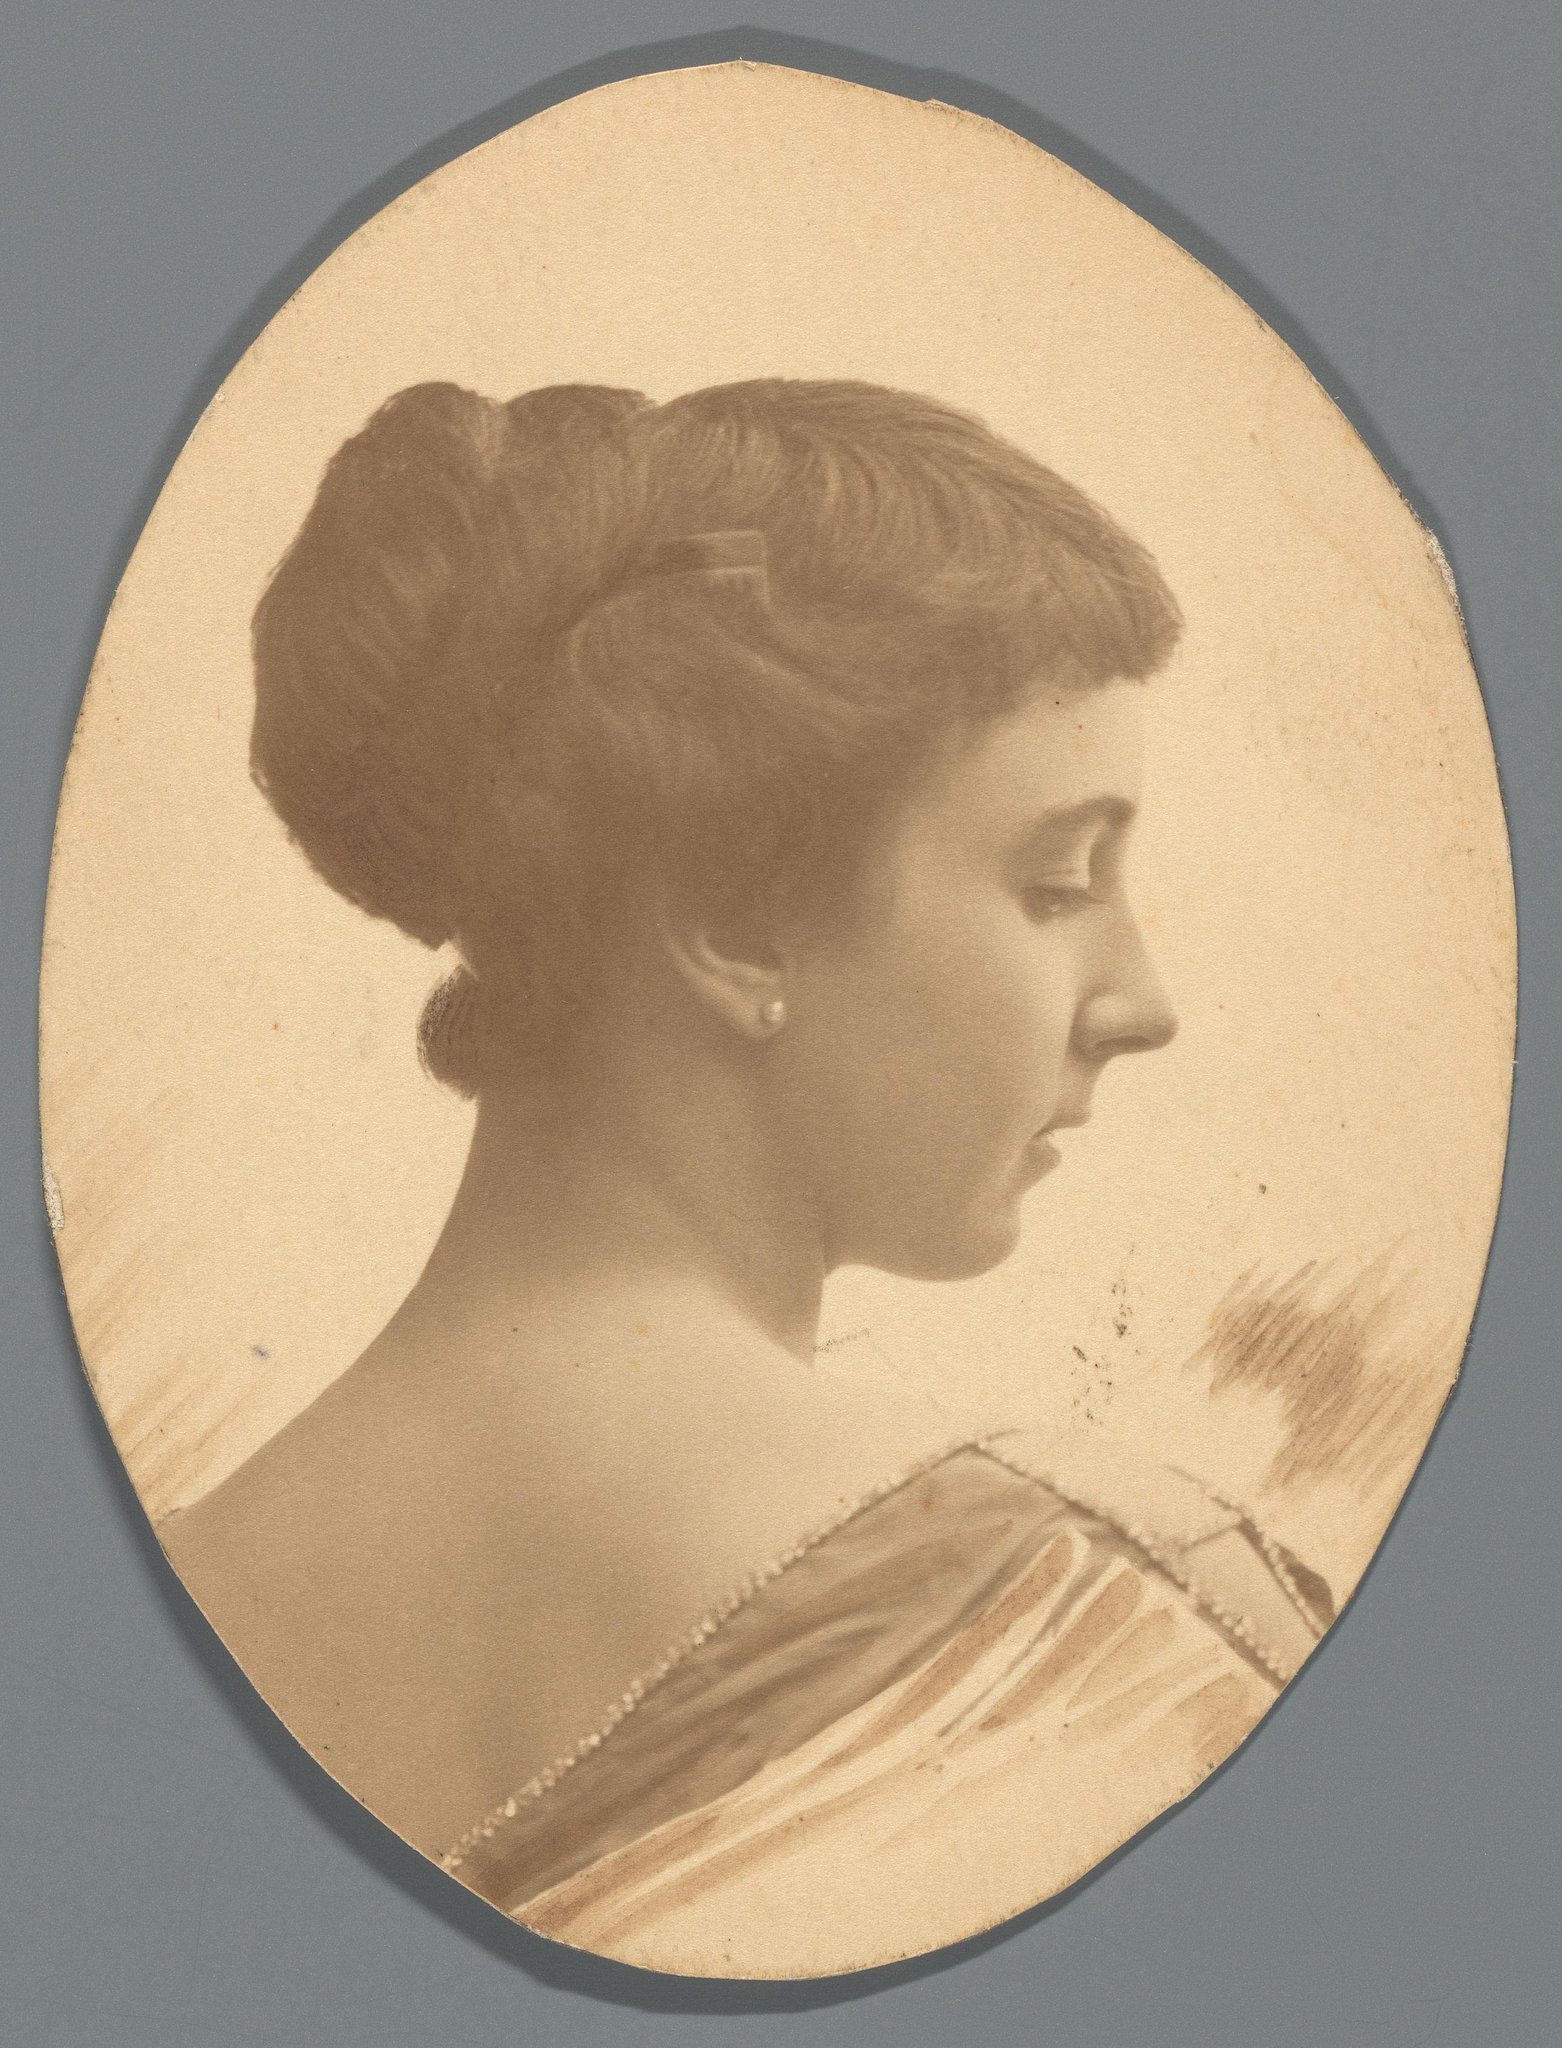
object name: photograph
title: Portret van Corrie van den Berg-Knottenbelt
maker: Anonymous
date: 1915-1925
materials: cardboard, photographic support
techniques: albumen print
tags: corrie van den berg-knottenbelt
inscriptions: name: ‘Corrie vdBerg / Knottenbelt’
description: Ovaal uitgeknipt profielportret van jonge vrouw met deels ontblote rug.